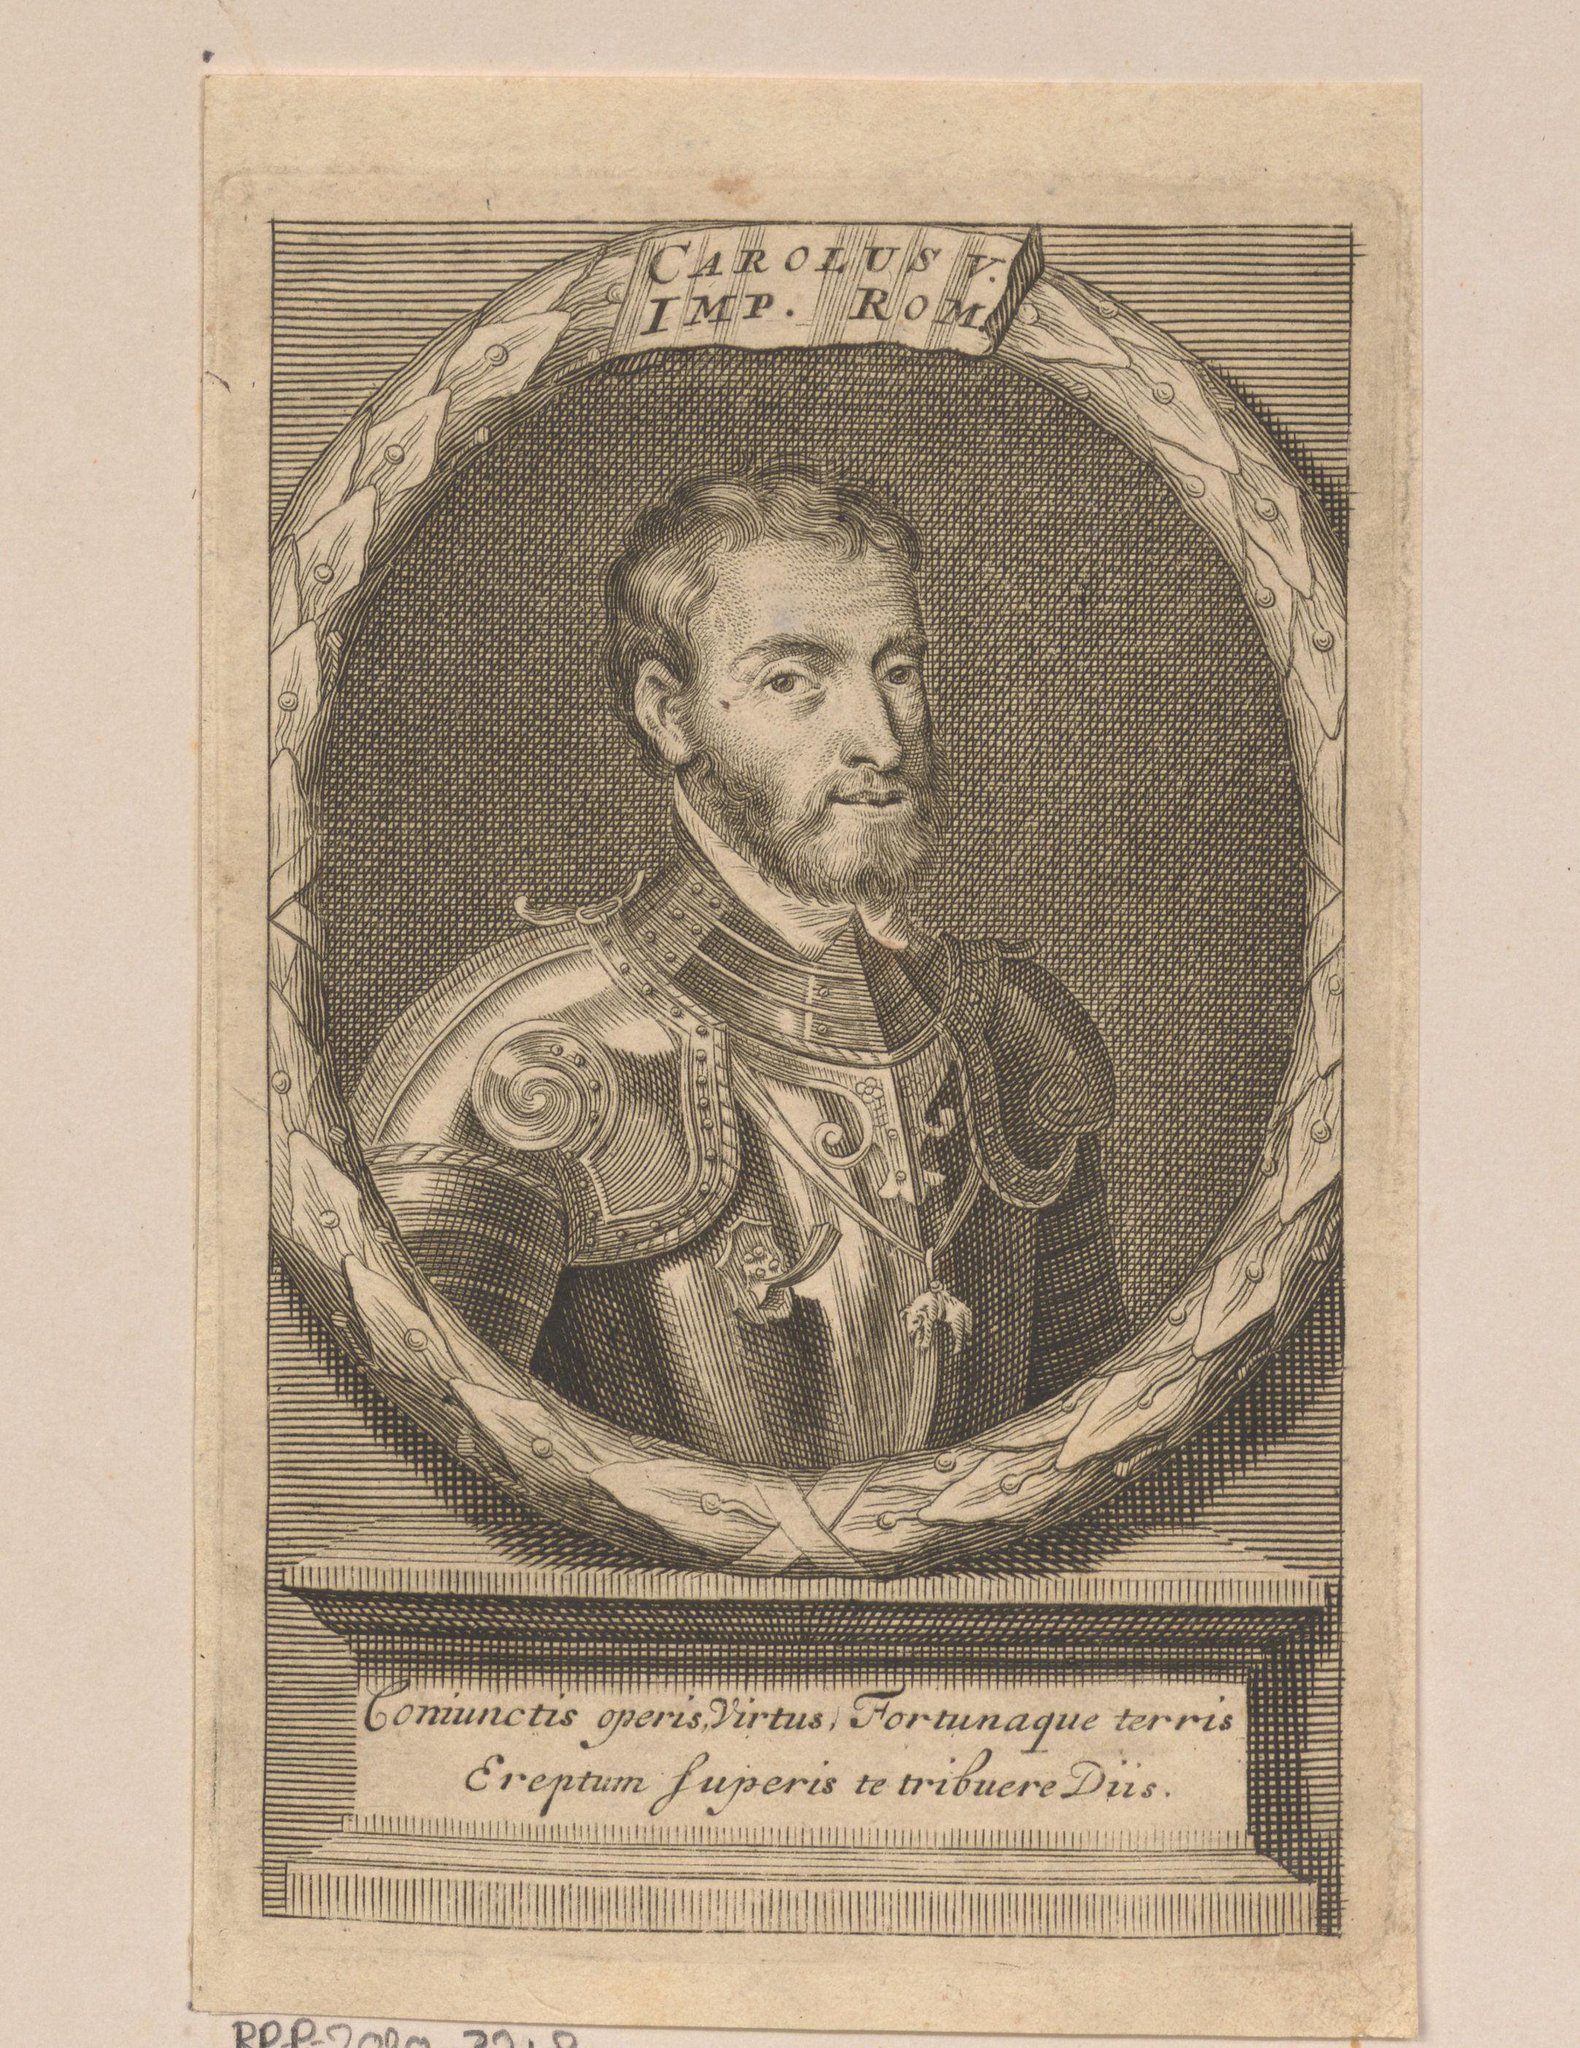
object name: print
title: Portret van keizer Karel V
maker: Anonymous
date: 1700-1710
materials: paper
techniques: engraving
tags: ghent, charles v (holy roman emperor and king of spain), historical persons, knighthood order of the golden fleece, king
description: Prent mogelijk uit: Leti, Gregorio. Vita dell' invittissimo imperadore Carlo V (...). Amsterdam: George Gallet, 1700. Of uit een latere publicatie (1710).